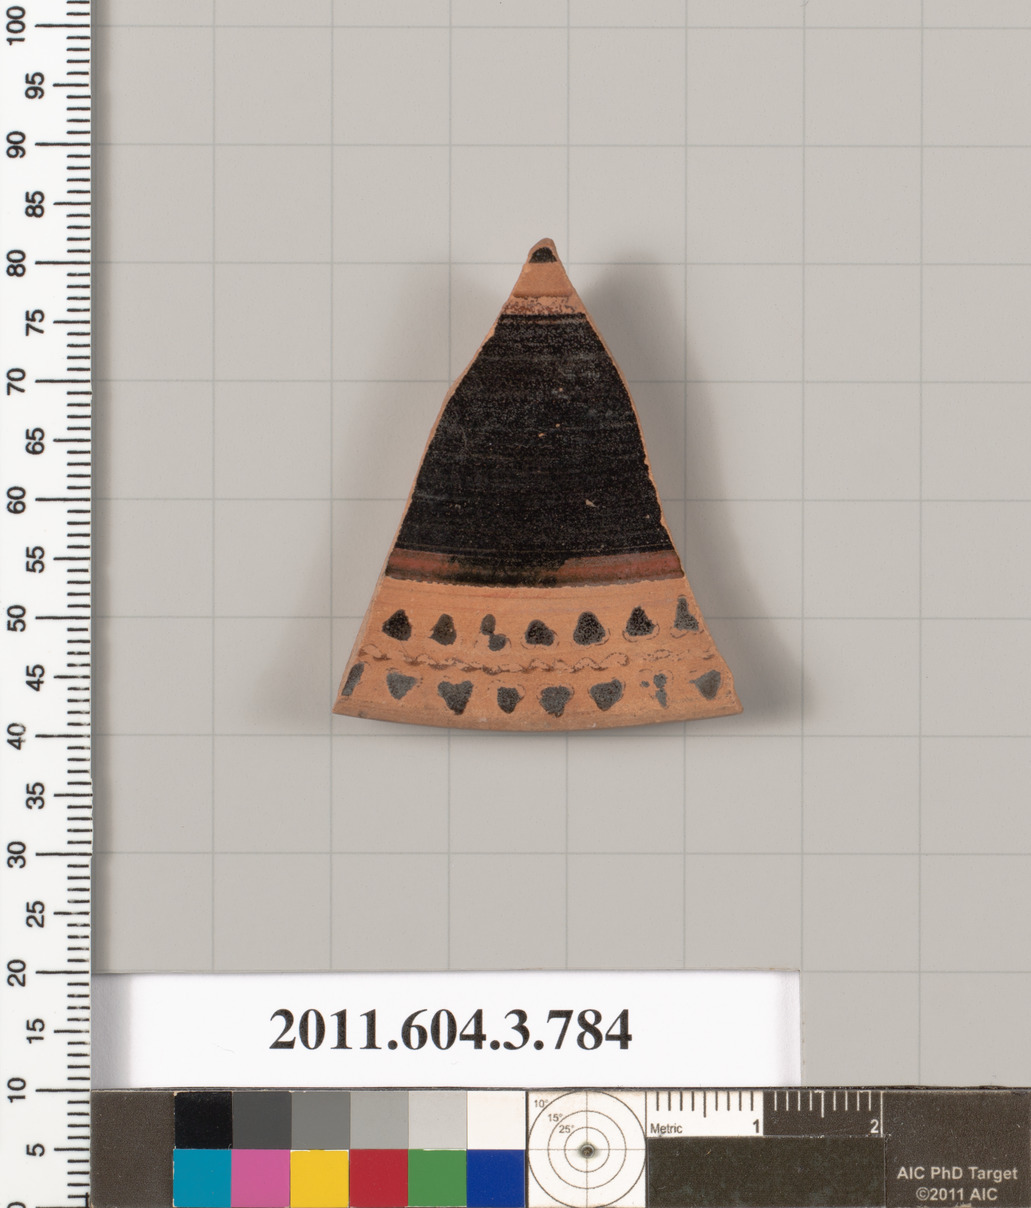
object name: lid fragment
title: Terracotta fragment of a lid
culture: greek, attic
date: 600-501 BCE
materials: terracotta